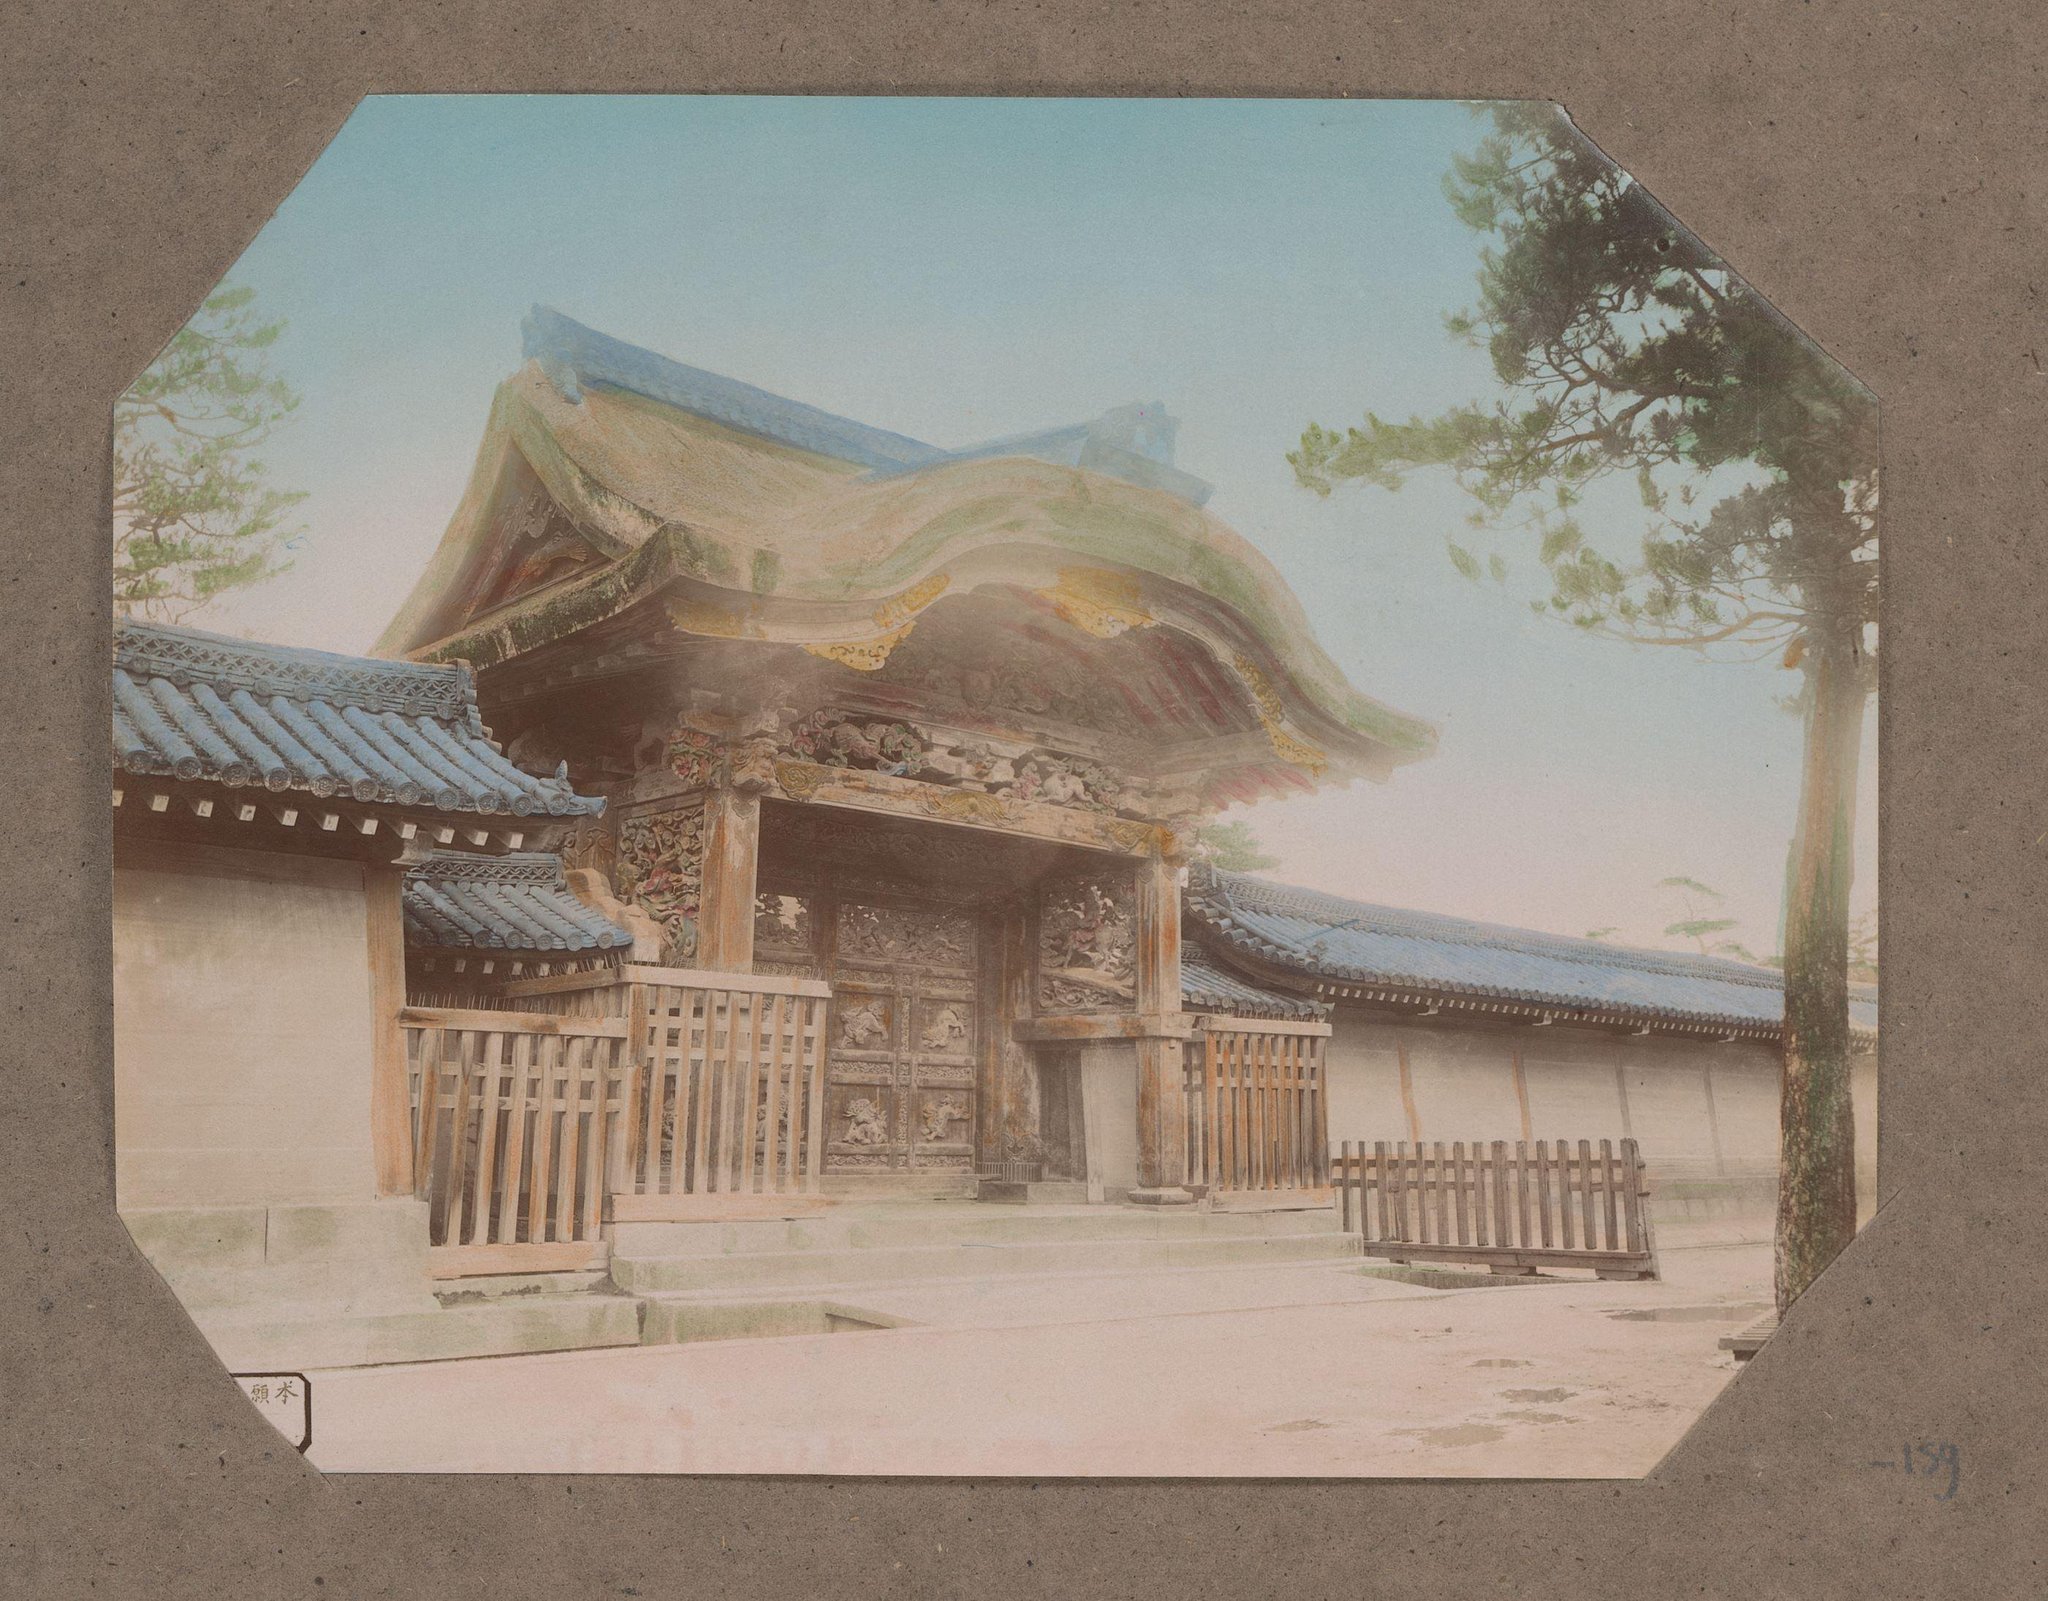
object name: photograph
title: Gezicht op de poort van de Nishi Hongan-ji tempel in Kyoto, Japan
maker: Anonymous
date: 1890-1903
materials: paper, photographic support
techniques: albumen print, hand coloring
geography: kyoto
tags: temple, shrine ~ hinduism, buddhism, jainism, gate, entrance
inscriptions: inscription: ‘Gate /of the Honguanji’